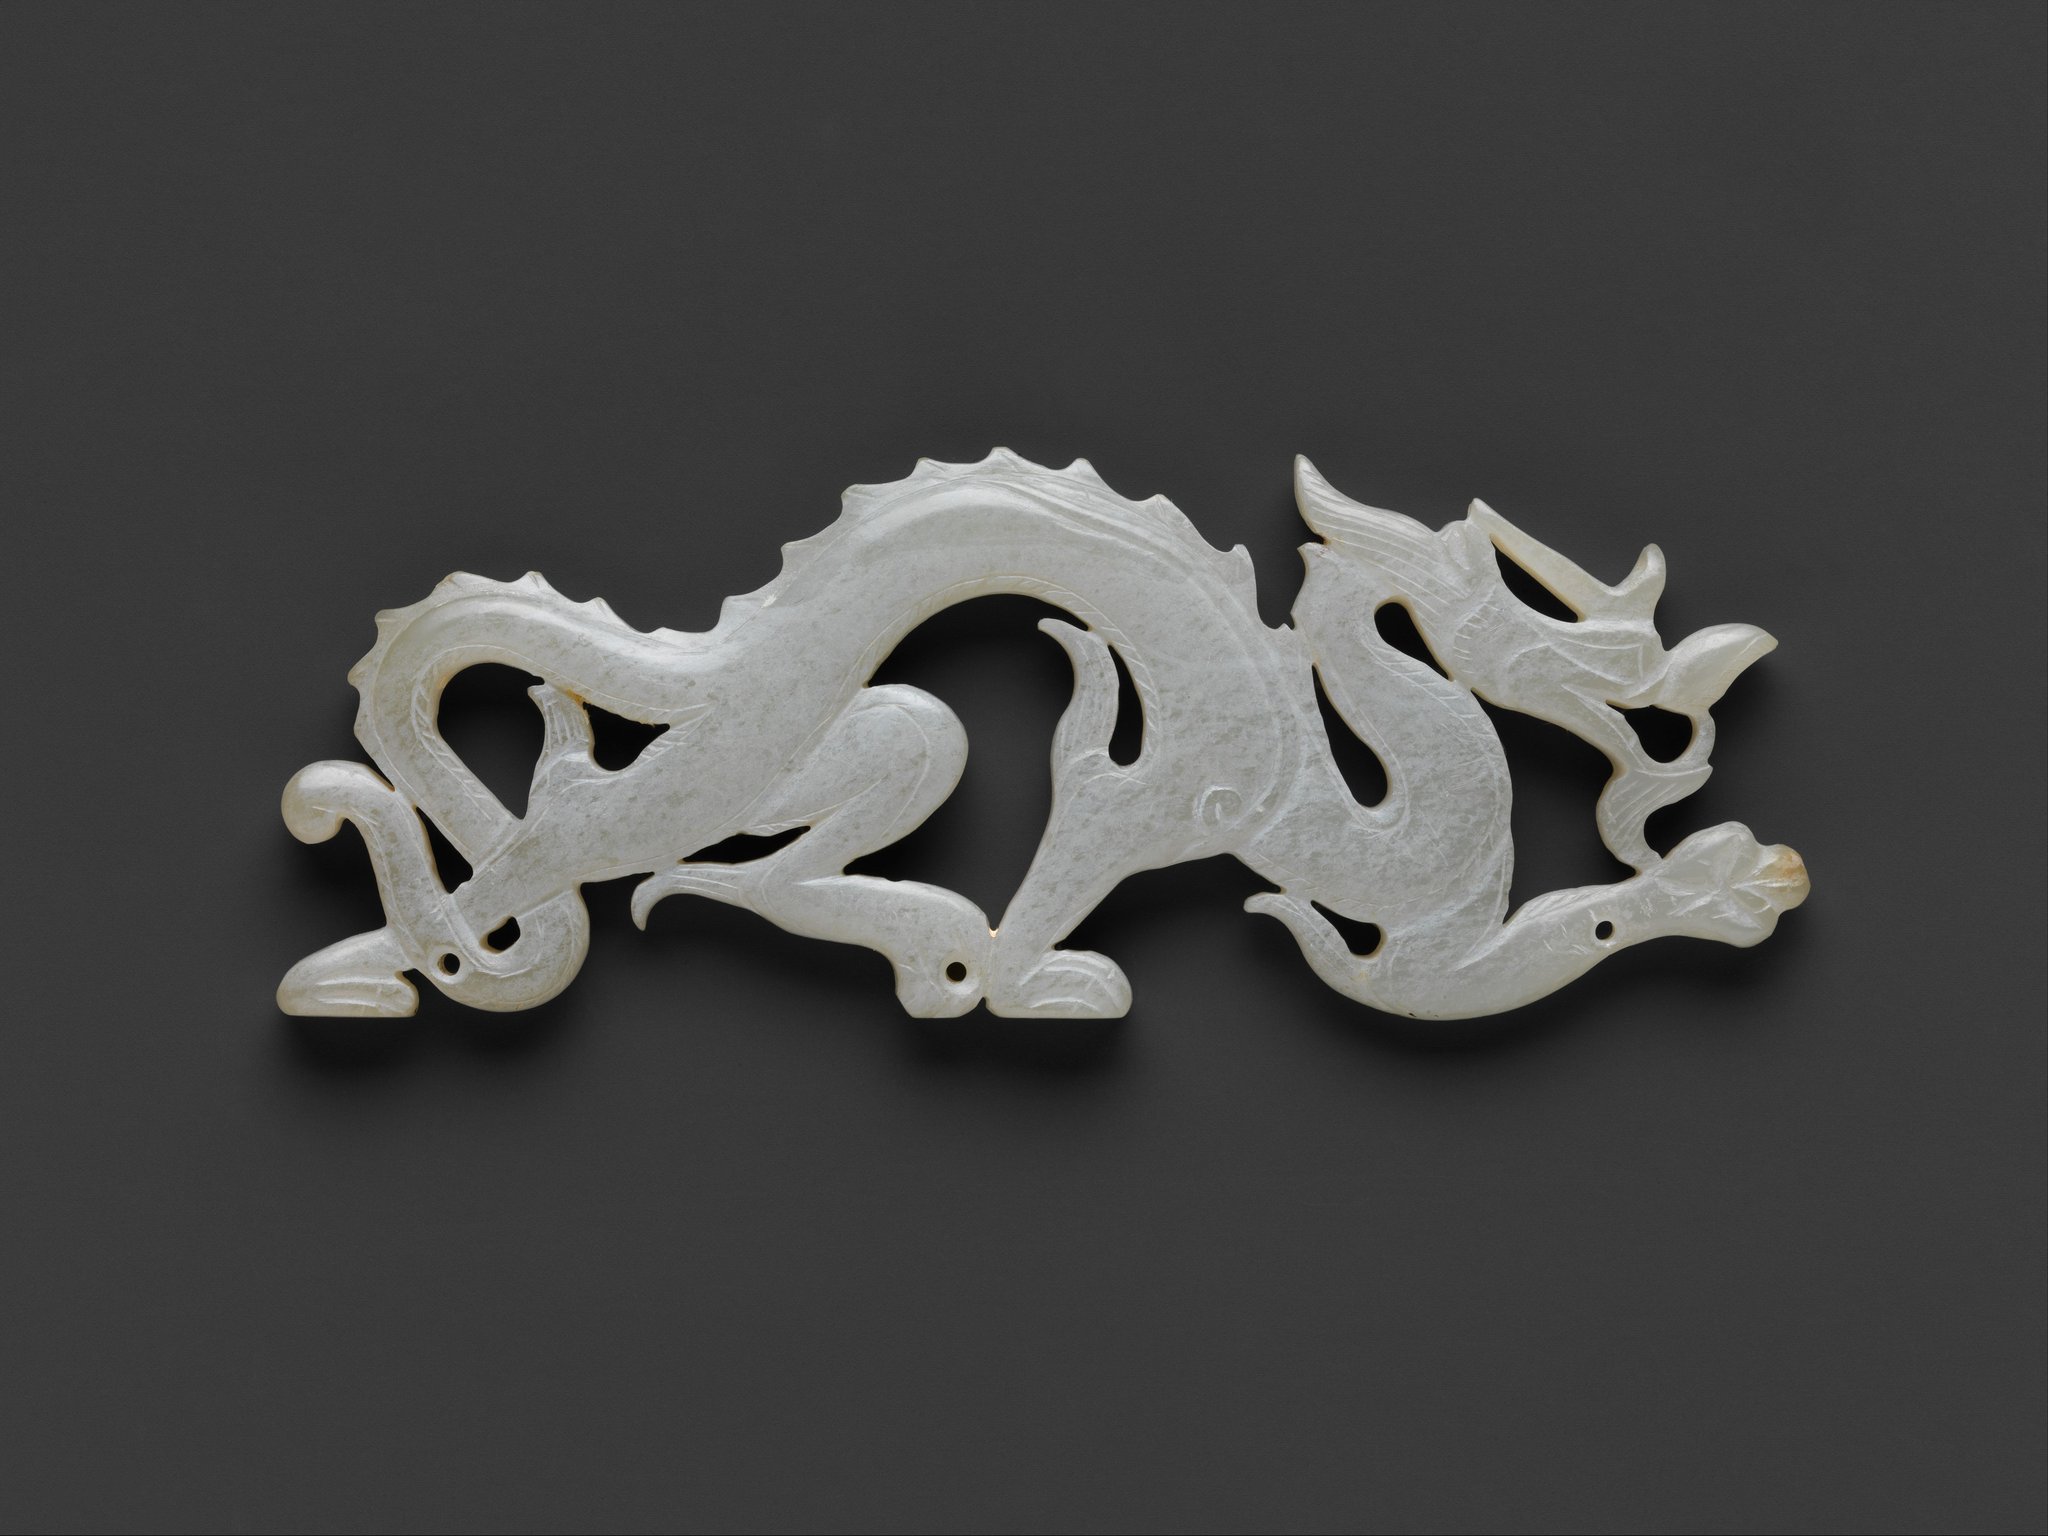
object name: plaque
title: Plaque in the shape of a dragon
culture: chinese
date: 901-1100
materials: jade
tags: dragons